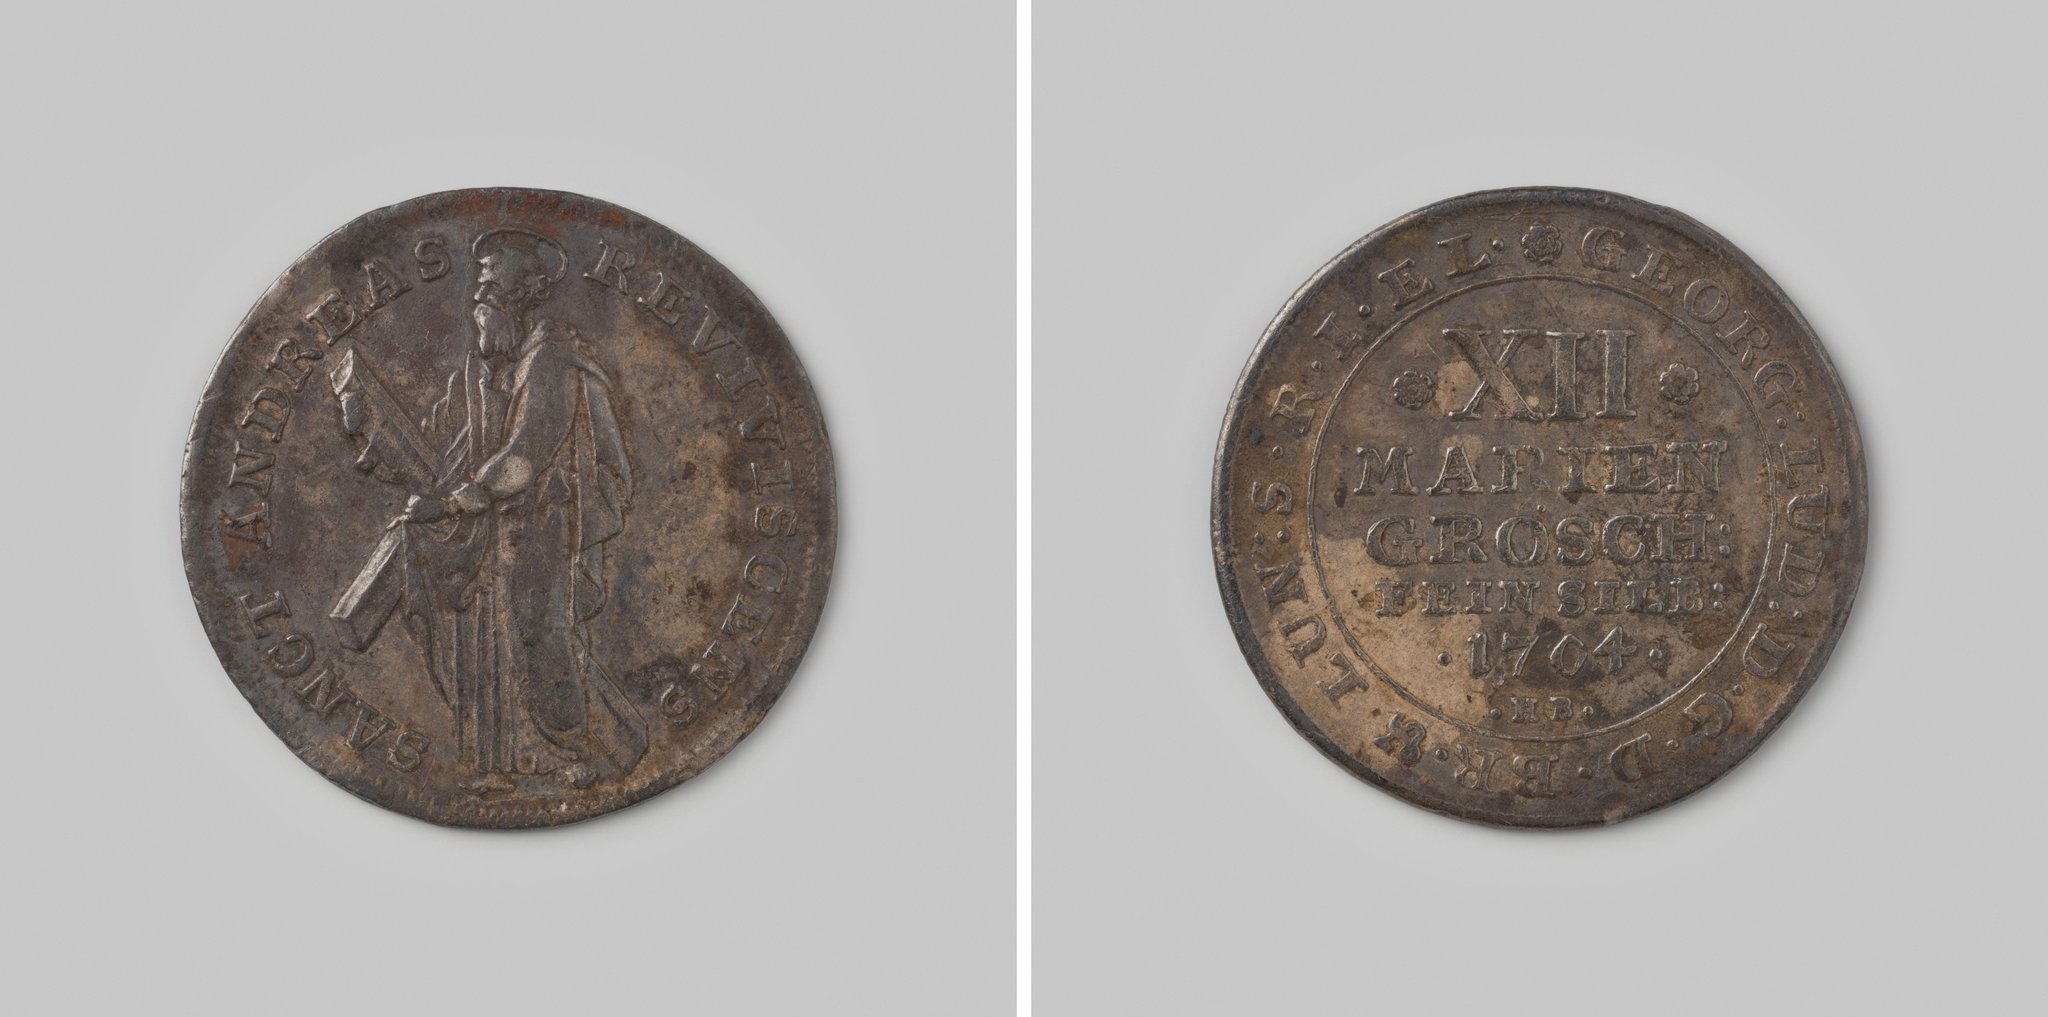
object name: coin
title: 12 mariëngroschen uit Brunswijk-Luneburg-Calenberg-Hannover van Georg I Ludwig,1704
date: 1704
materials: silver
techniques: striking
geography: clausthal-zellerfeld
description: Zilveren munt. Voorzijde: heilige Andreas met kruis. Keerzijde: waarde-aanduiding in vier regels, waaronder jaartal. Kartelrand.